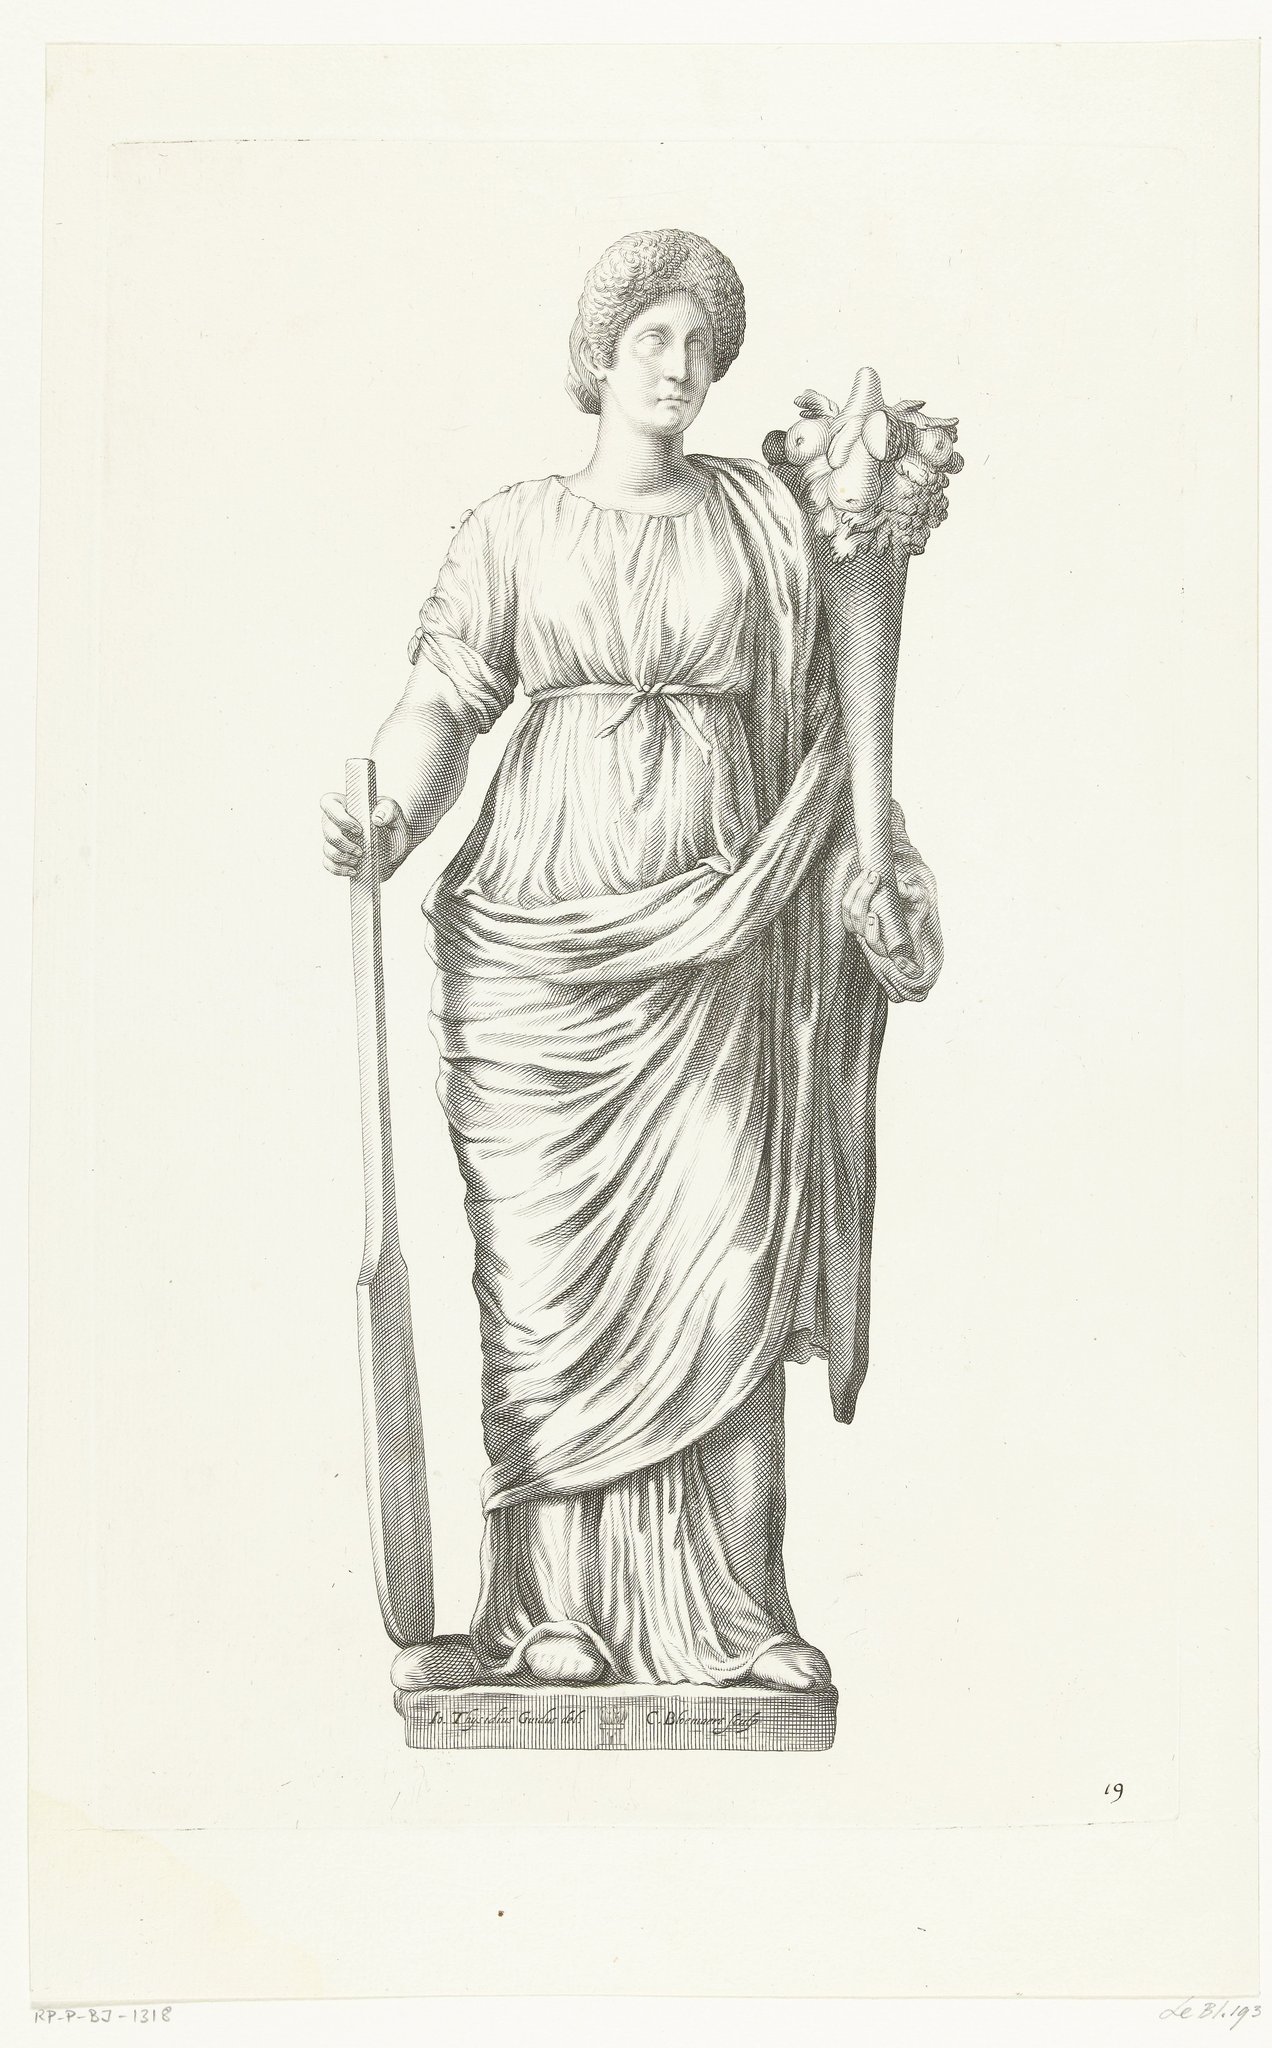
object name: print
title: Godin met hoorn des overvloeds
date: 1636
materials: paper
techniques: engraving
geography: rome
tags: piece of sculpture, reproduction of a piece of sculpture, gods of the earth and fertility ~ agriculture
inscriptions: number: ‘19’, collector's mark: Lugt 2228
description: Een beeld van een godin met een hoorn des overvloeds gevuld met vruchten in haar arm. Met haar andere hand leunt ze op een roer. Het beeld is afkomstig uit de collectie van Vincenzo Giustiniani, wiens wapen op de sokkel te zien is.